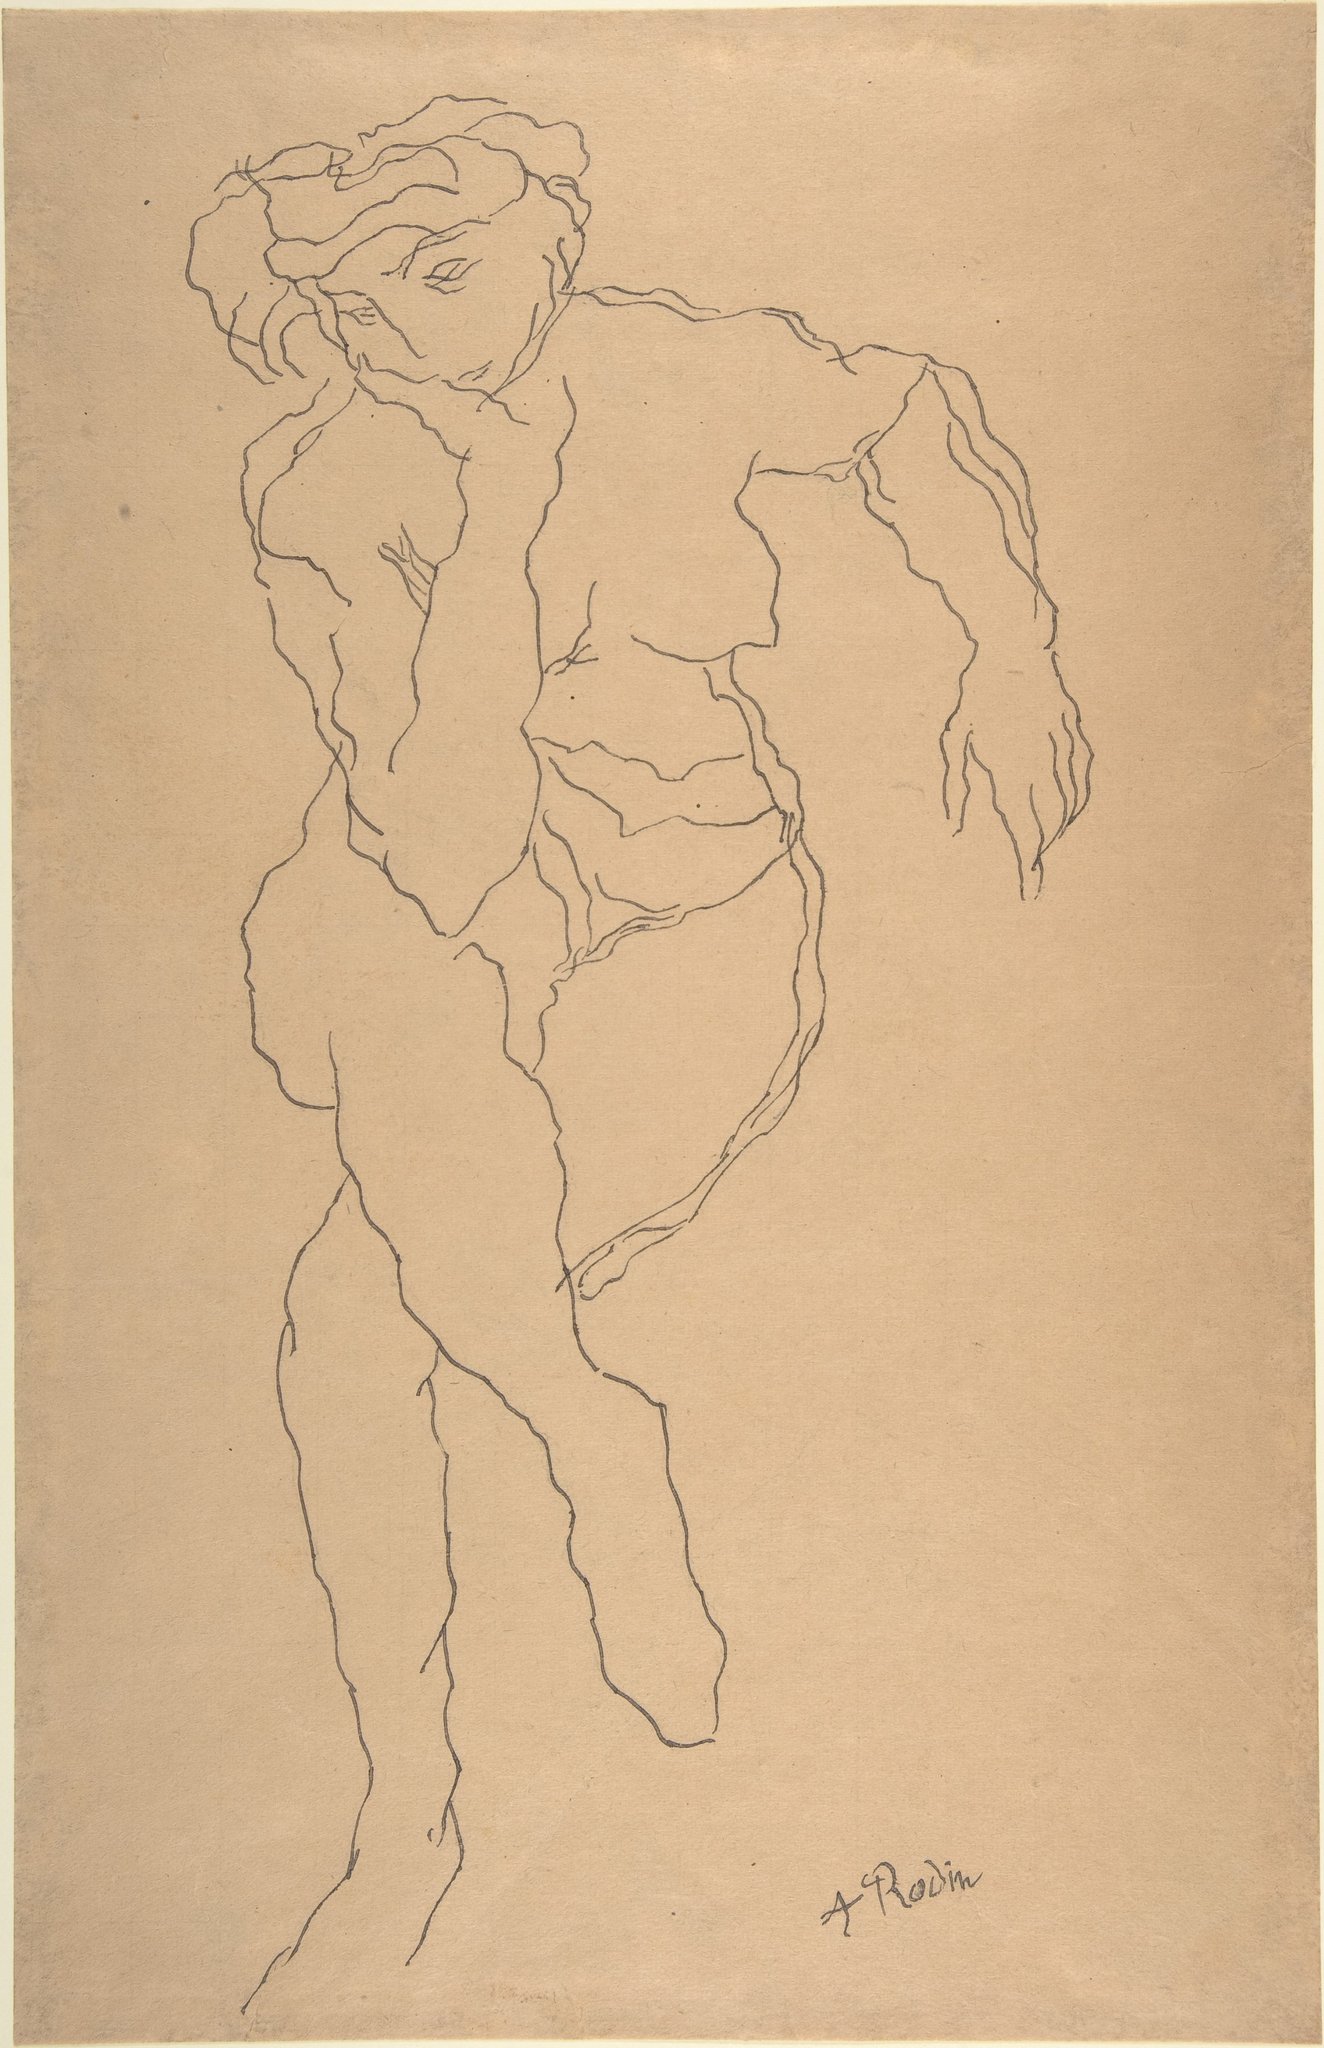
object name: drawing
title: Copy after a reproduction of a Rodin drawing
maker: Anonymous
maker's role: artist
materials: ink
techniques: pen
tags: female nudes